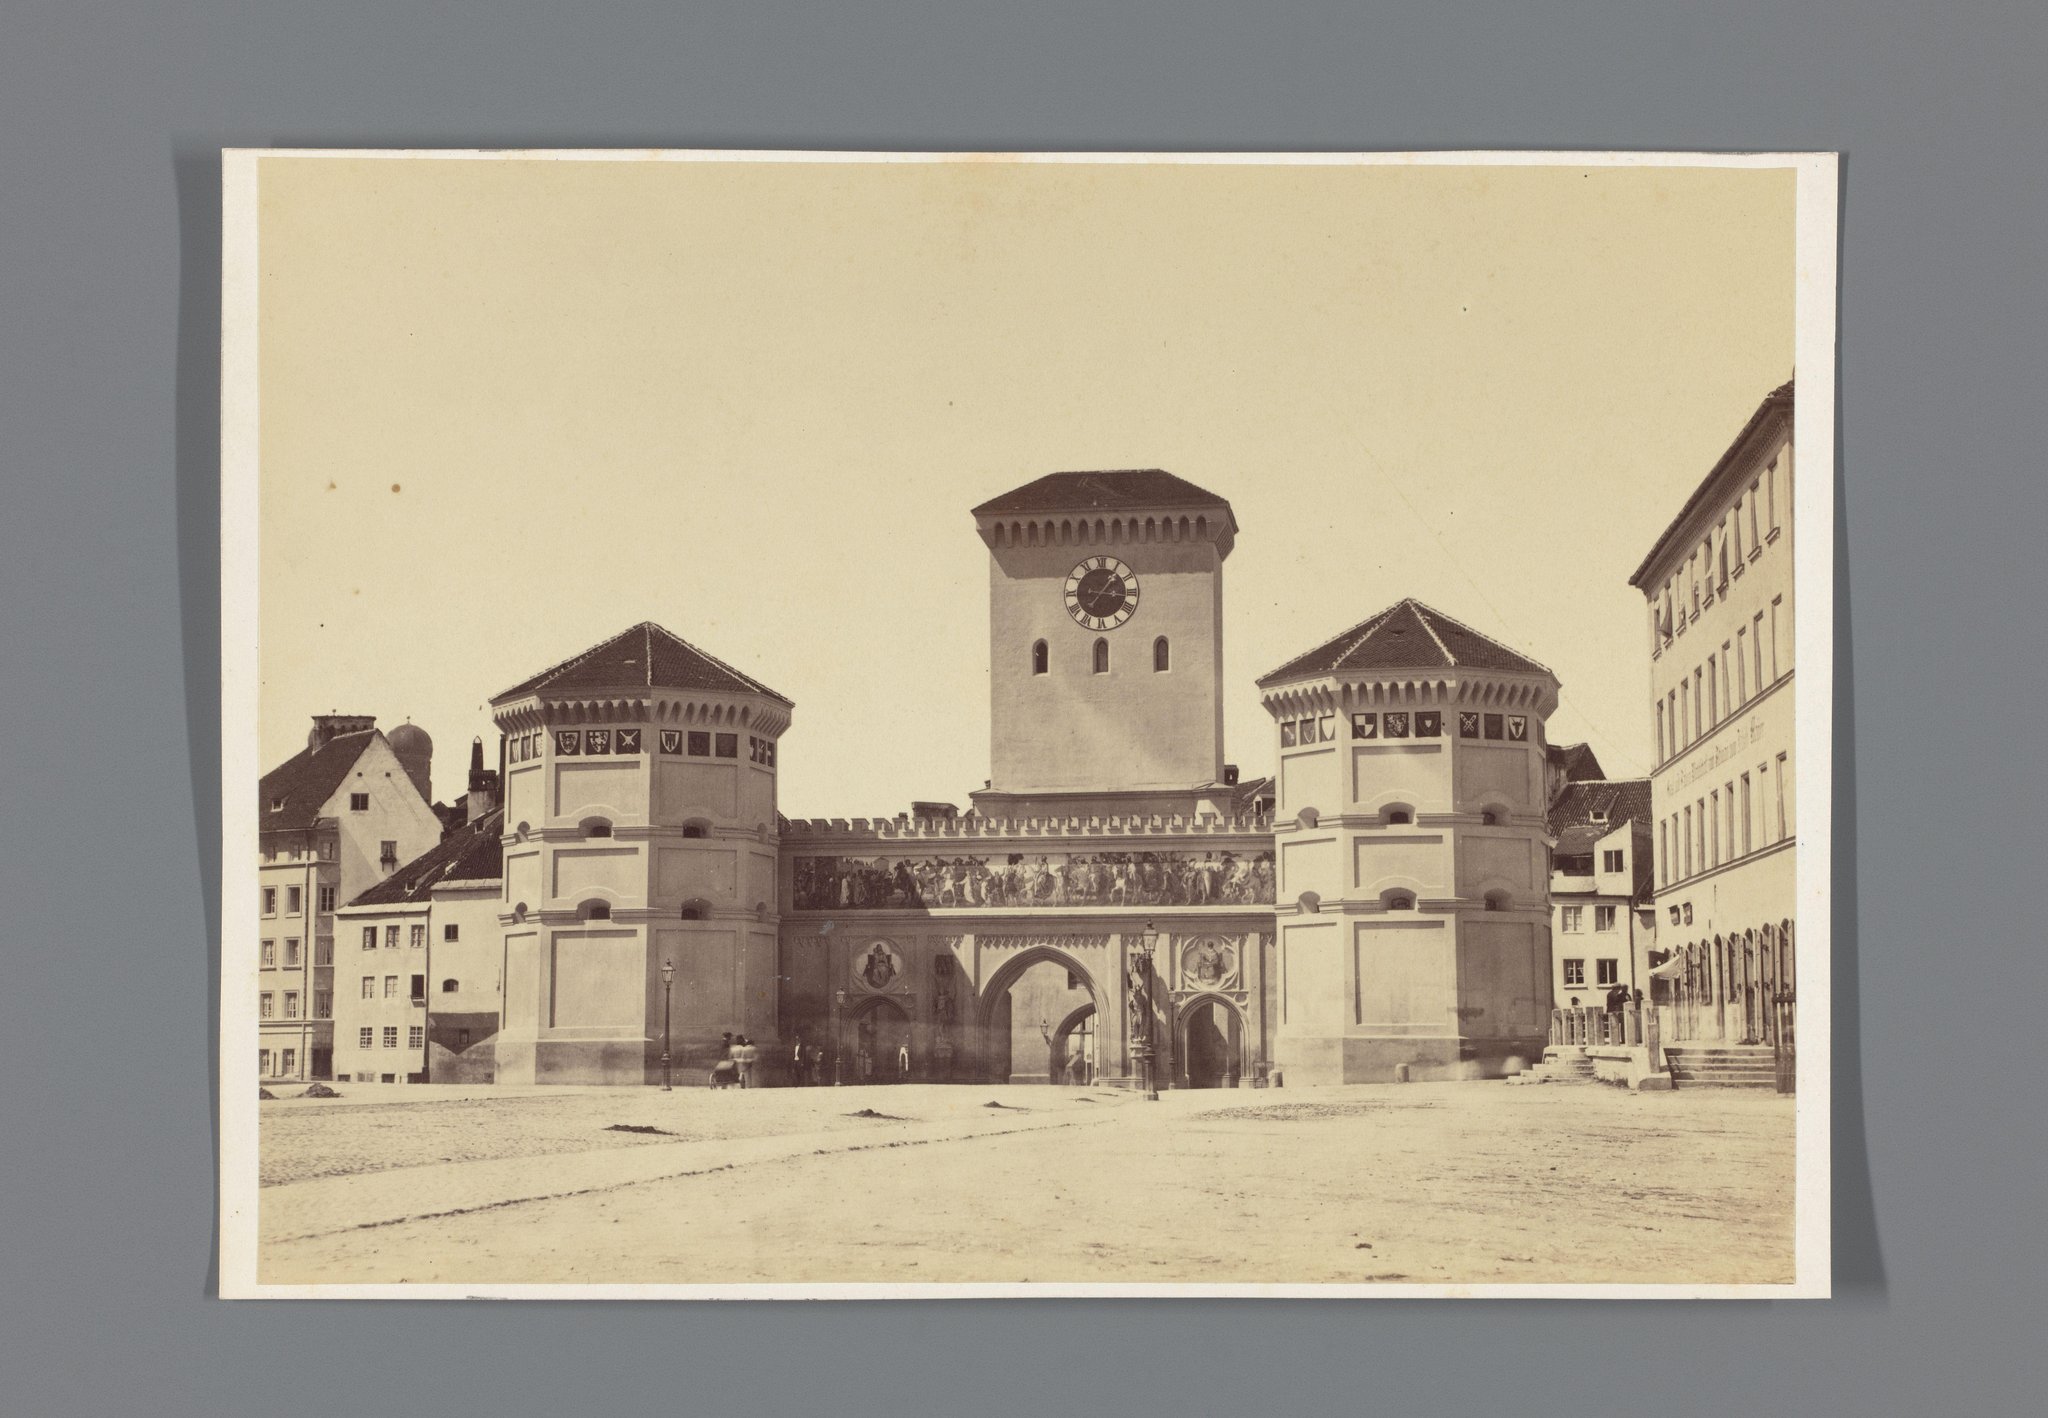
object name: photograph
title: München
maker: Anonymous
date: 1850-1900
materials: cardboard, photographic support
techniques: albumen print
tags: münchen